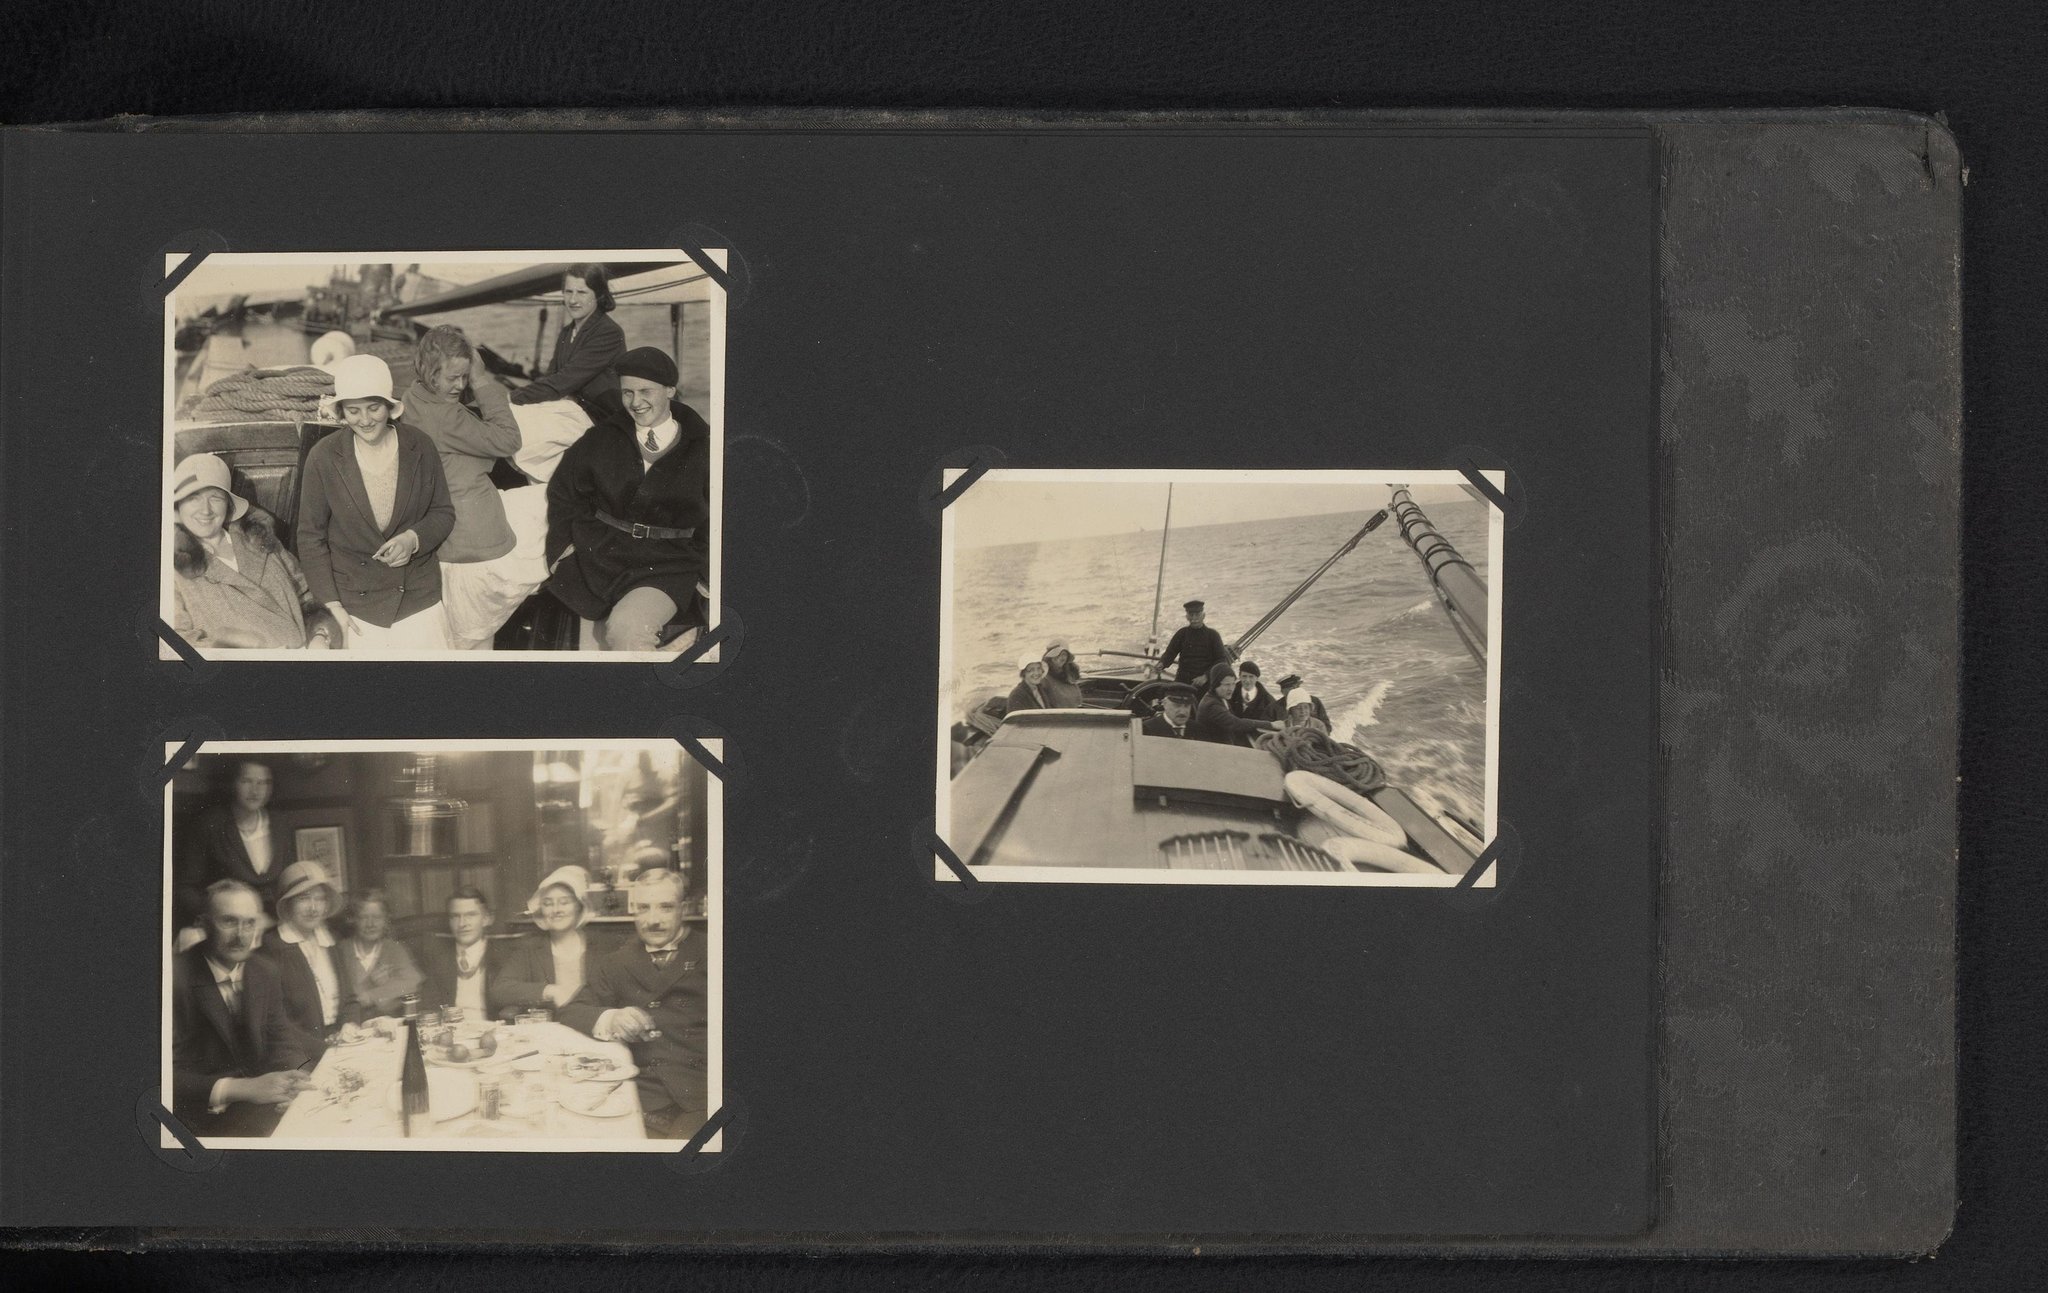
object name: photograph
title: Drie foto's van een gezelschap op een zeilschip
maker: hendrik herman van den berg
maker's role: amateurfotograaf, jurist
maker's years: 1875-1944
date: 1929-1930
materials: paper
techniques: gelatin silver print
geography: netherlands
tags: sailing-ship, sailing-boat, crew and passengers ~ ship, netherlands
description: Deze foto's maken deel uit van een album.